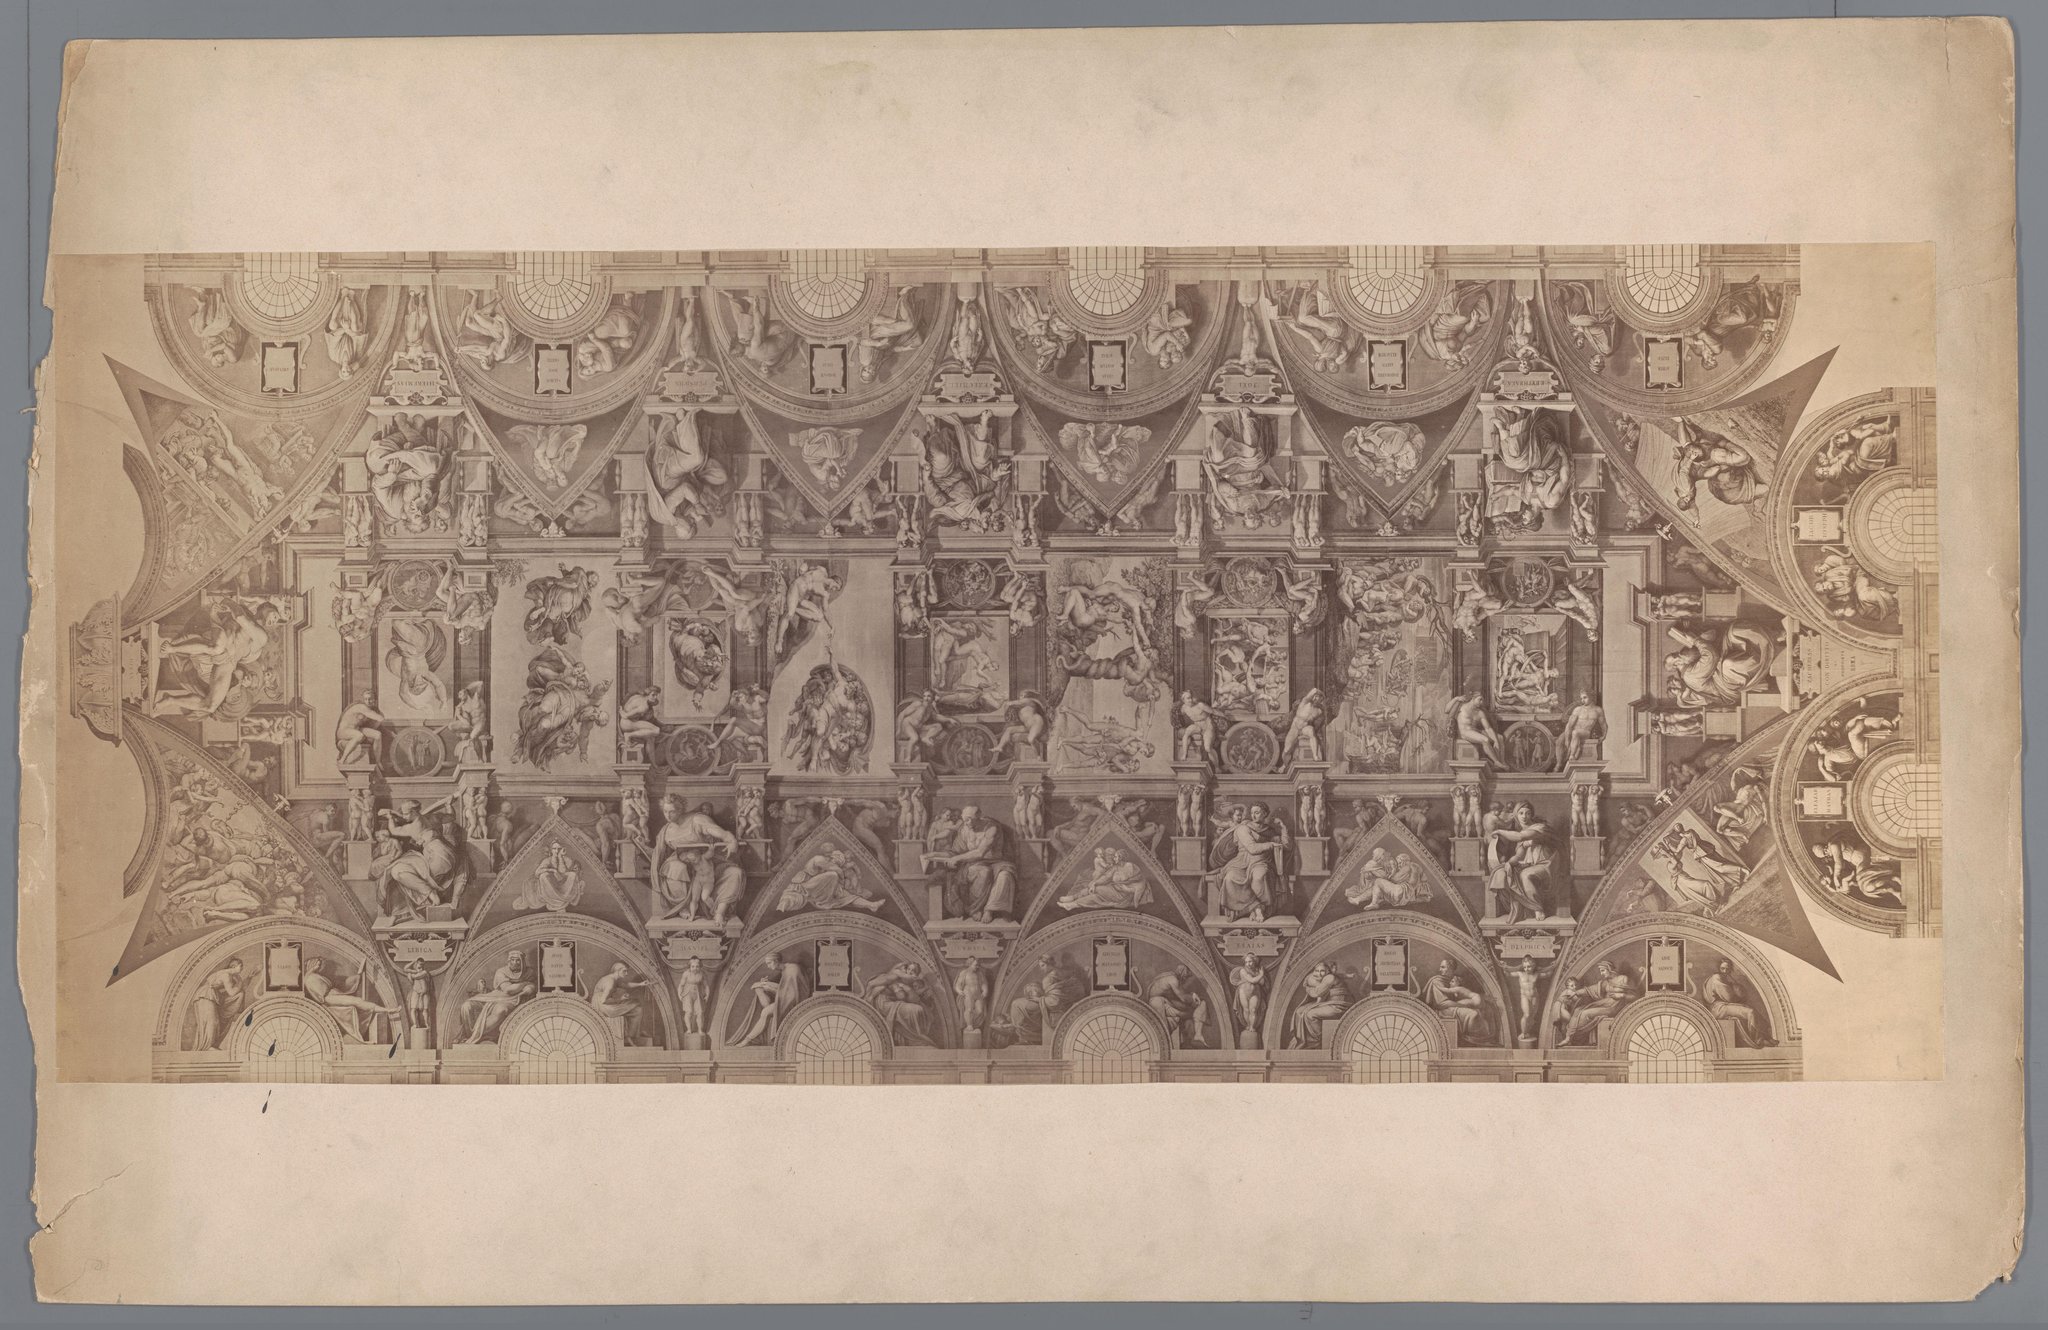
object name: reproduction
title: Fotoreproductie van de fresco's op het plafond van de Sixtijnse kapel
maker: Anonymous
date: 1860-1890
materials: paper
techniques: albumen print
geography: vatican city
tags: picture, painting, (decorated) ceiling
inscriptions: collector's mark: Lugt 3937